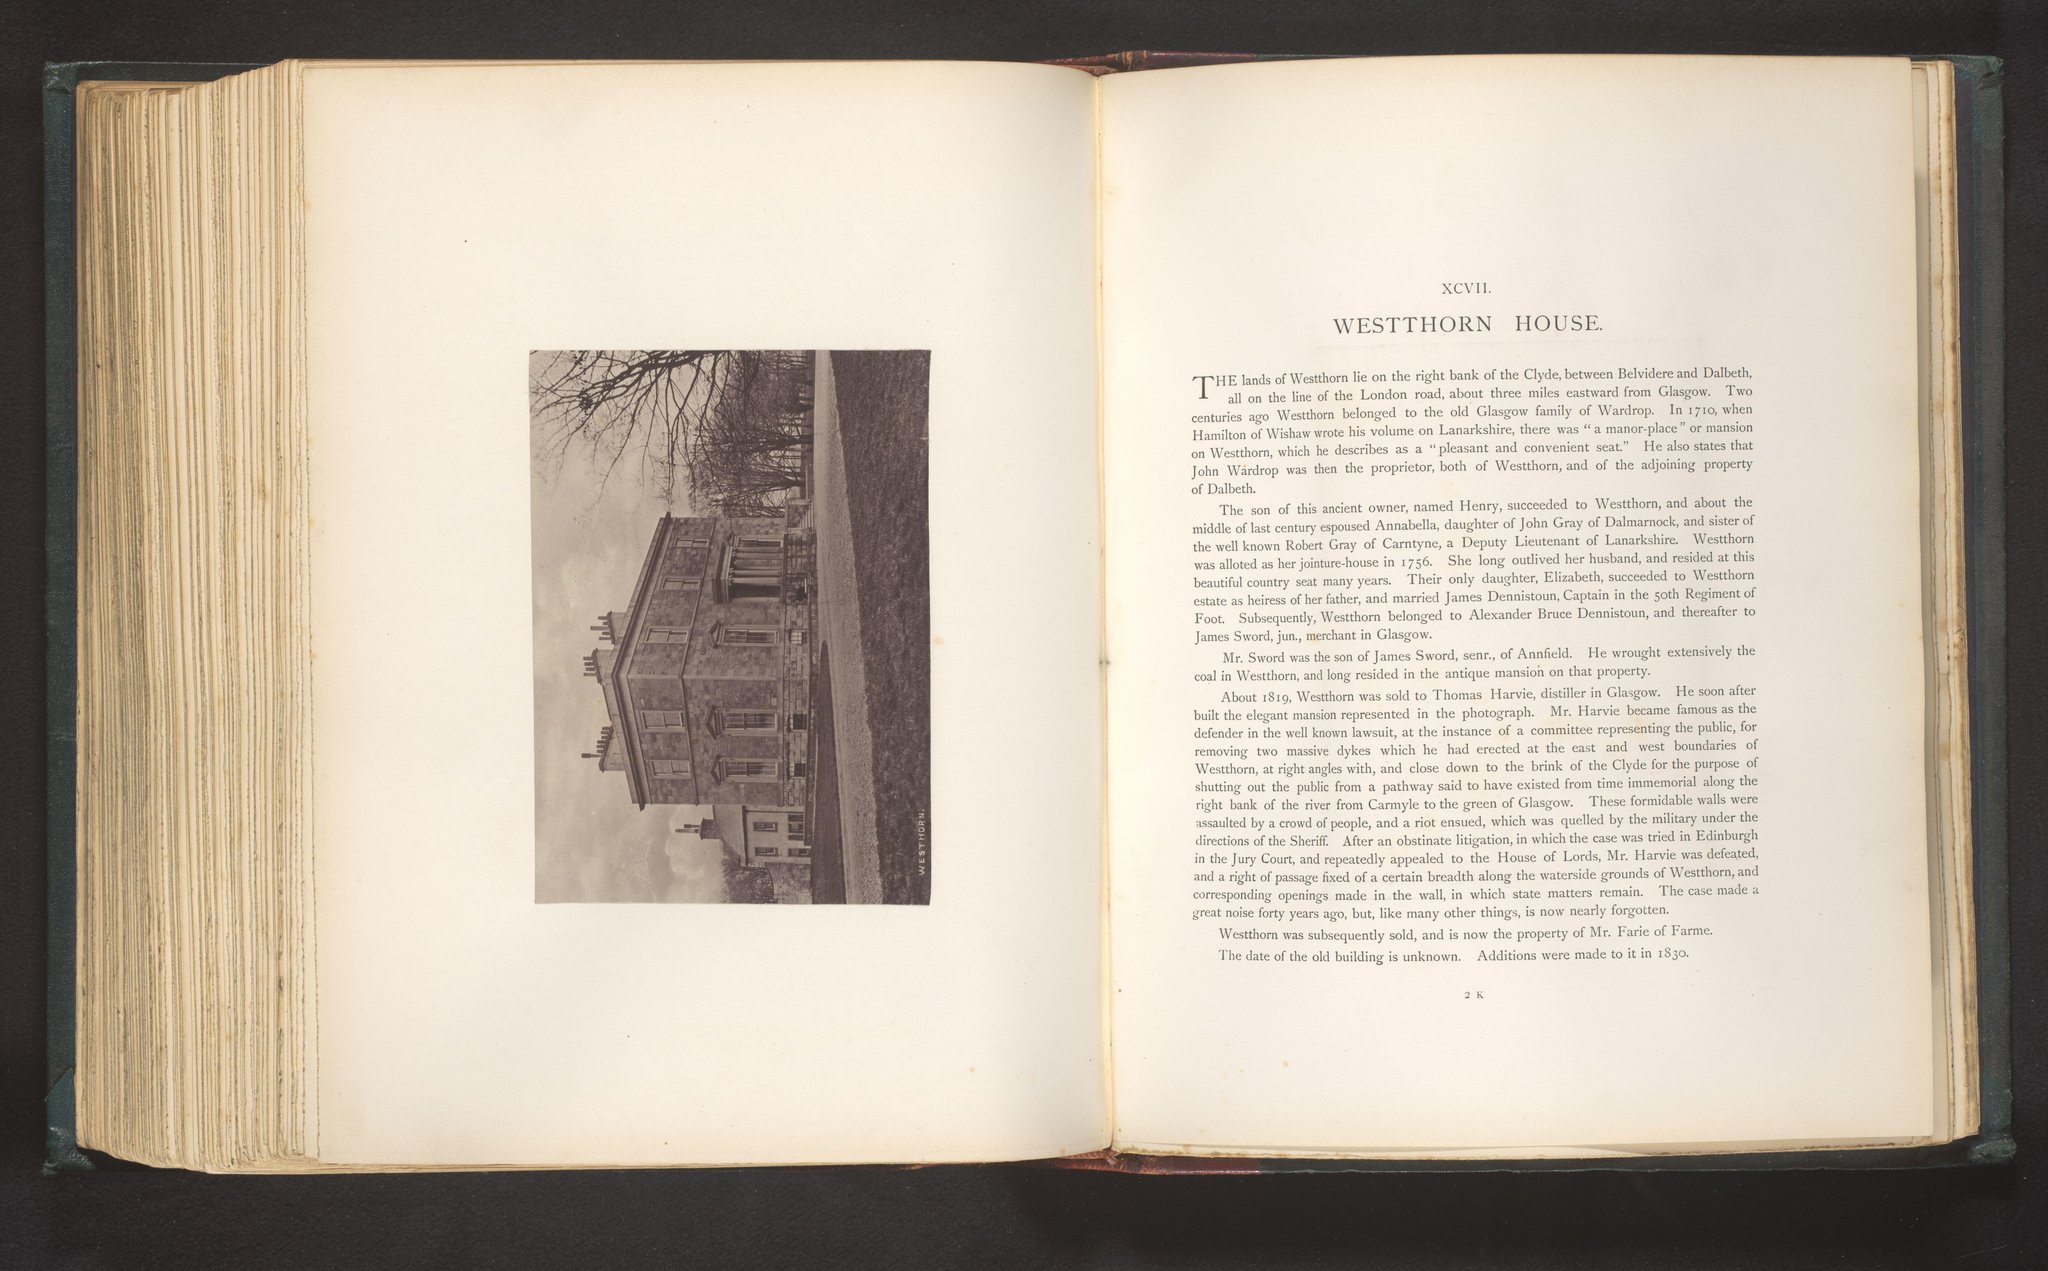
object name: photograph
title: Westthorn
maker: thomas annan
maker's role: fotograaf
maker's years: 1829-1887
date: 1868-1878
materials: paper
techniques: carbon print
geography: scotland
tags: rural housing, e.g. country-house, villa, cottage, façade (of house or building)